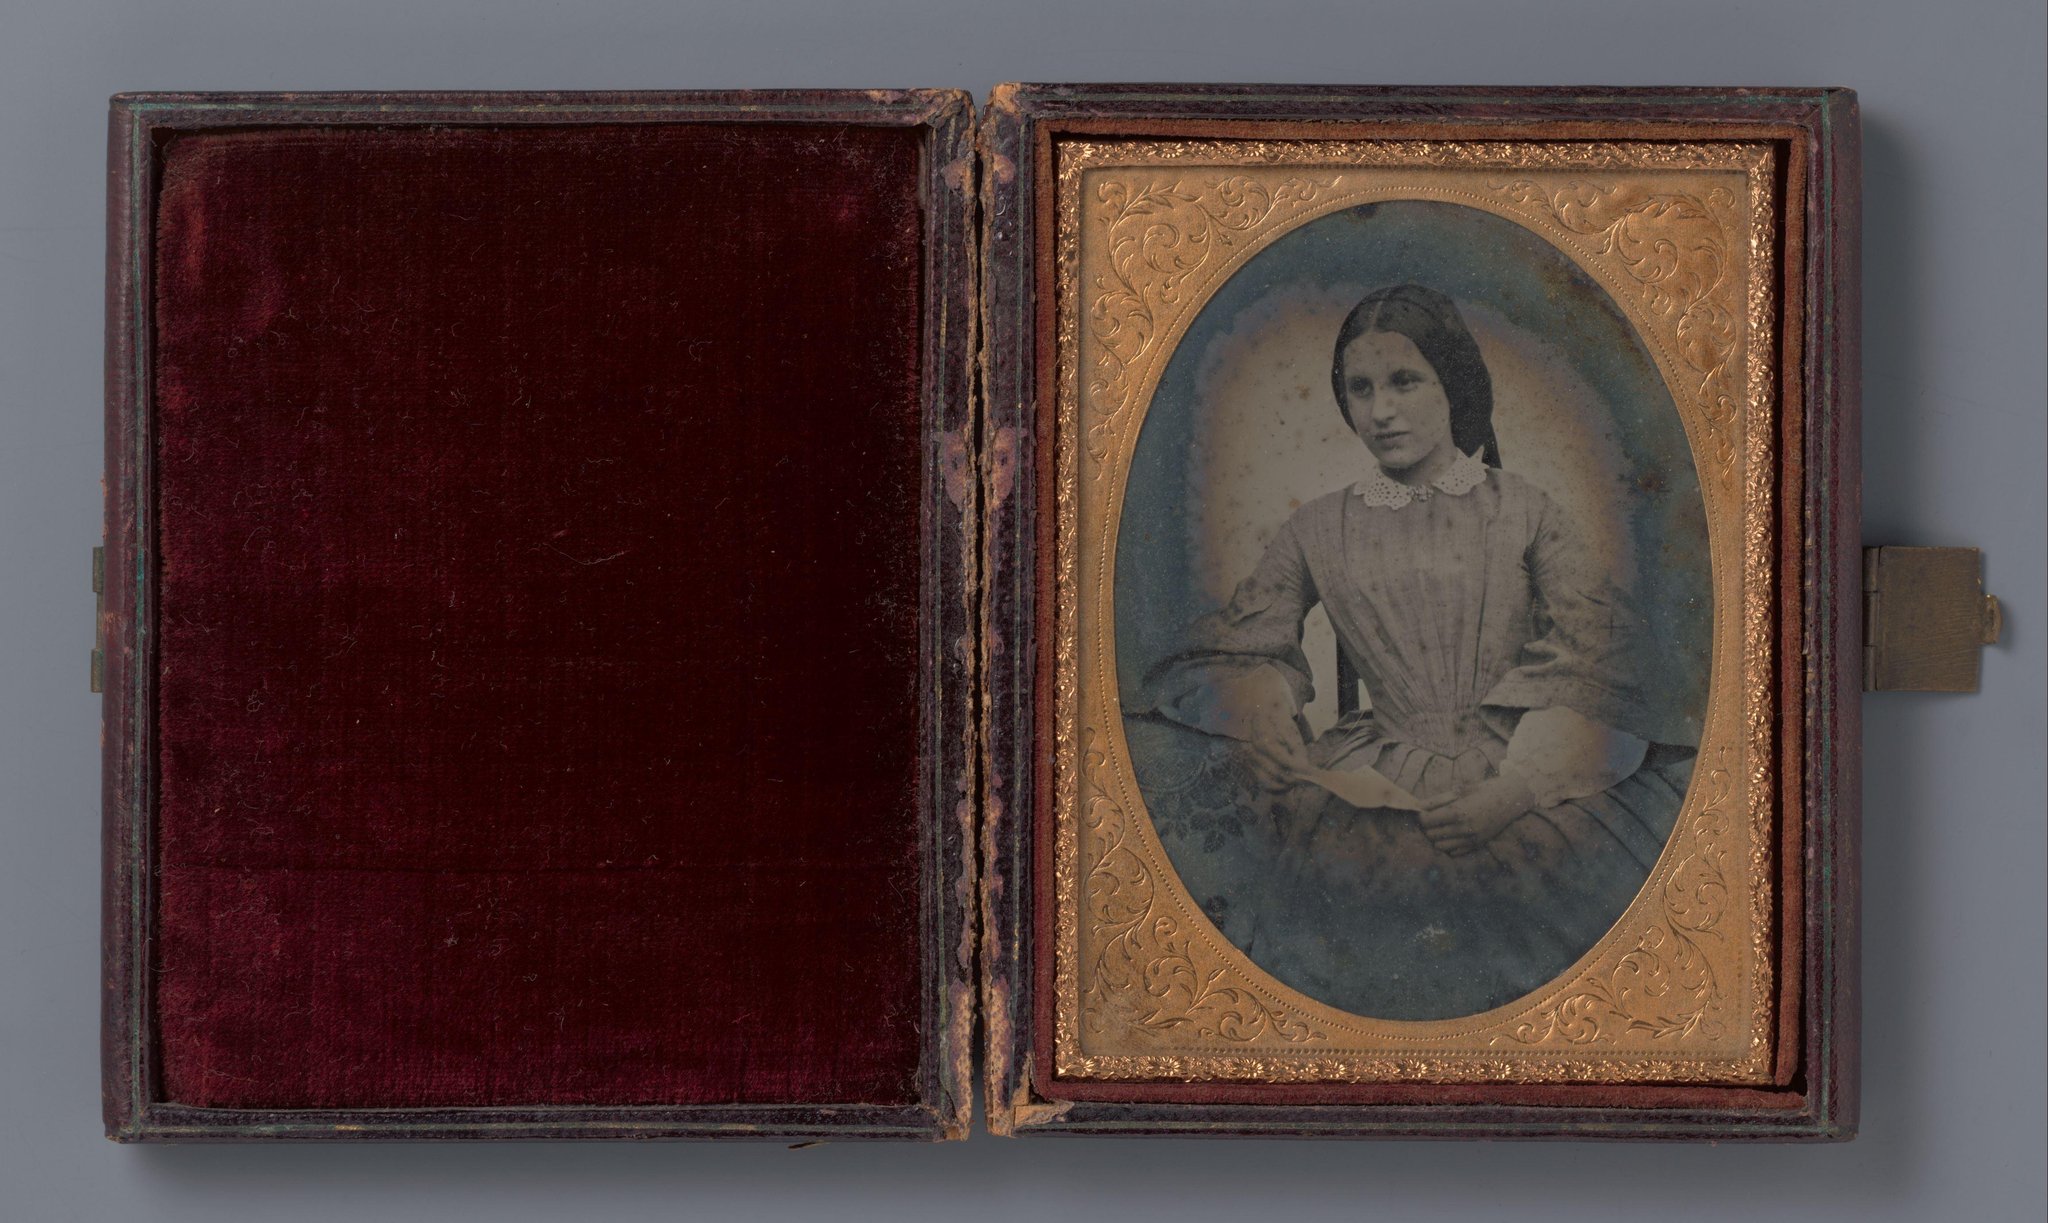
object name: photograph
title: Portret van een onbekende jonge vrouw met brief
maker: Anonymous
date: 1855-1870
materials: glass, leather, metal, velvet, wood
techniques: ambrotype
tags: adolescent, young woman, maiden, historical persons not known by name - bb - woman, letter, envelope